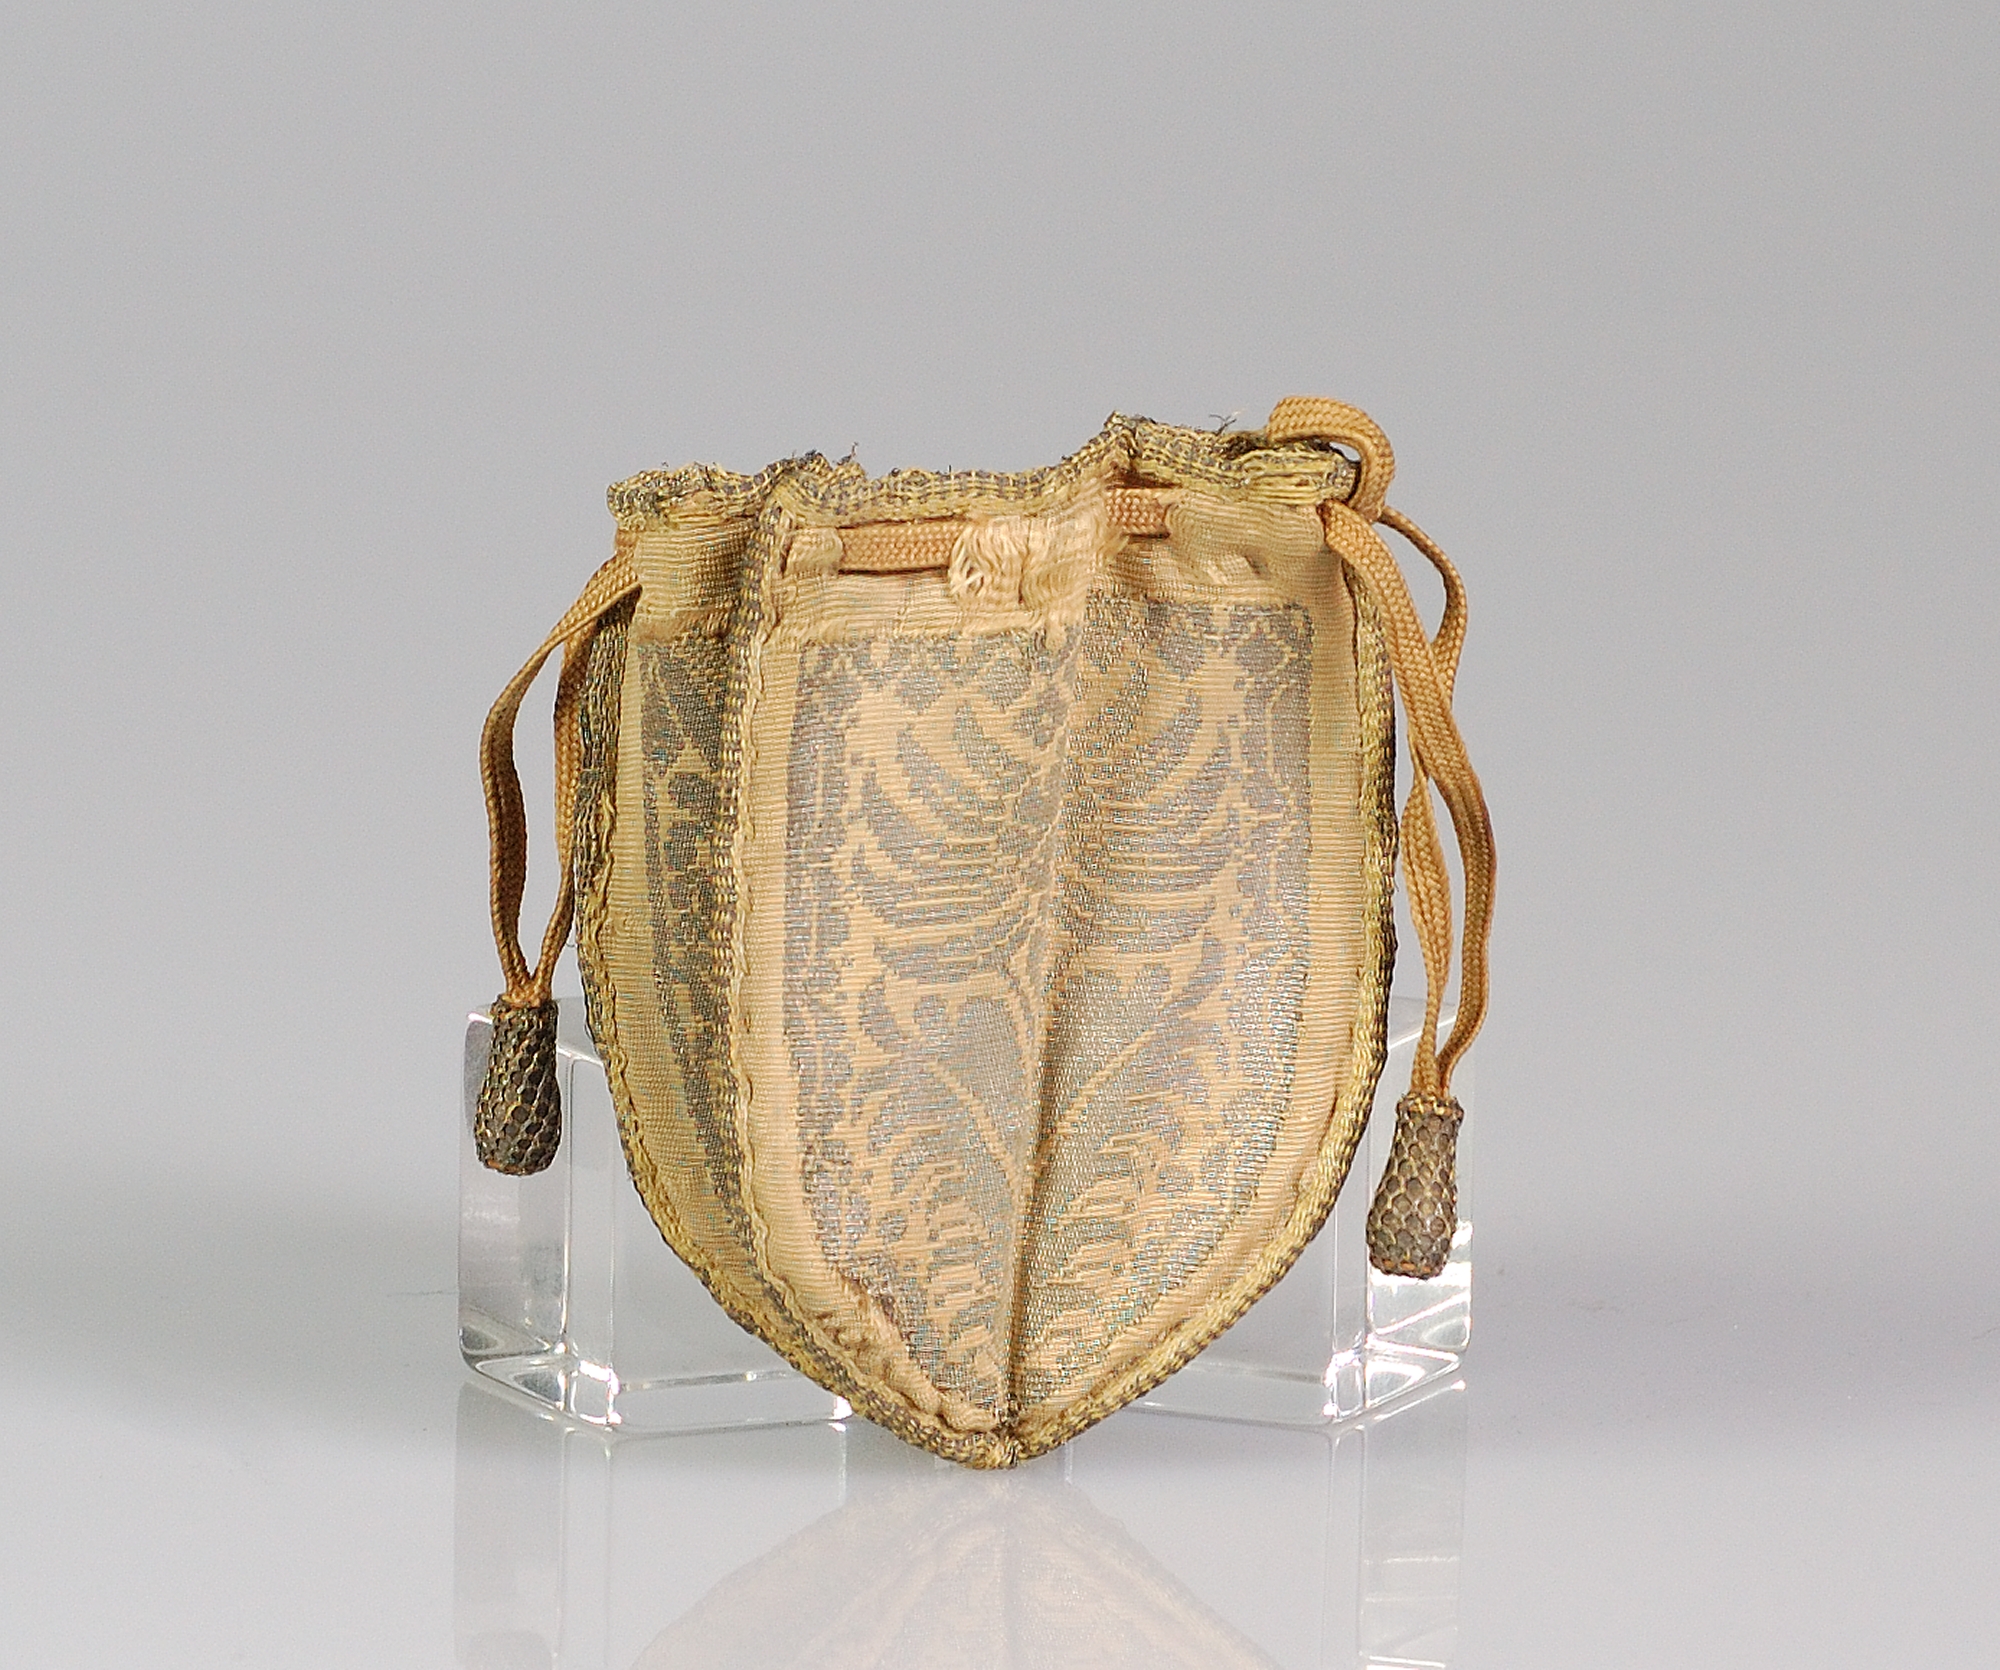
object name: pouch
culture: european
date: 1676-1700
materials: silk